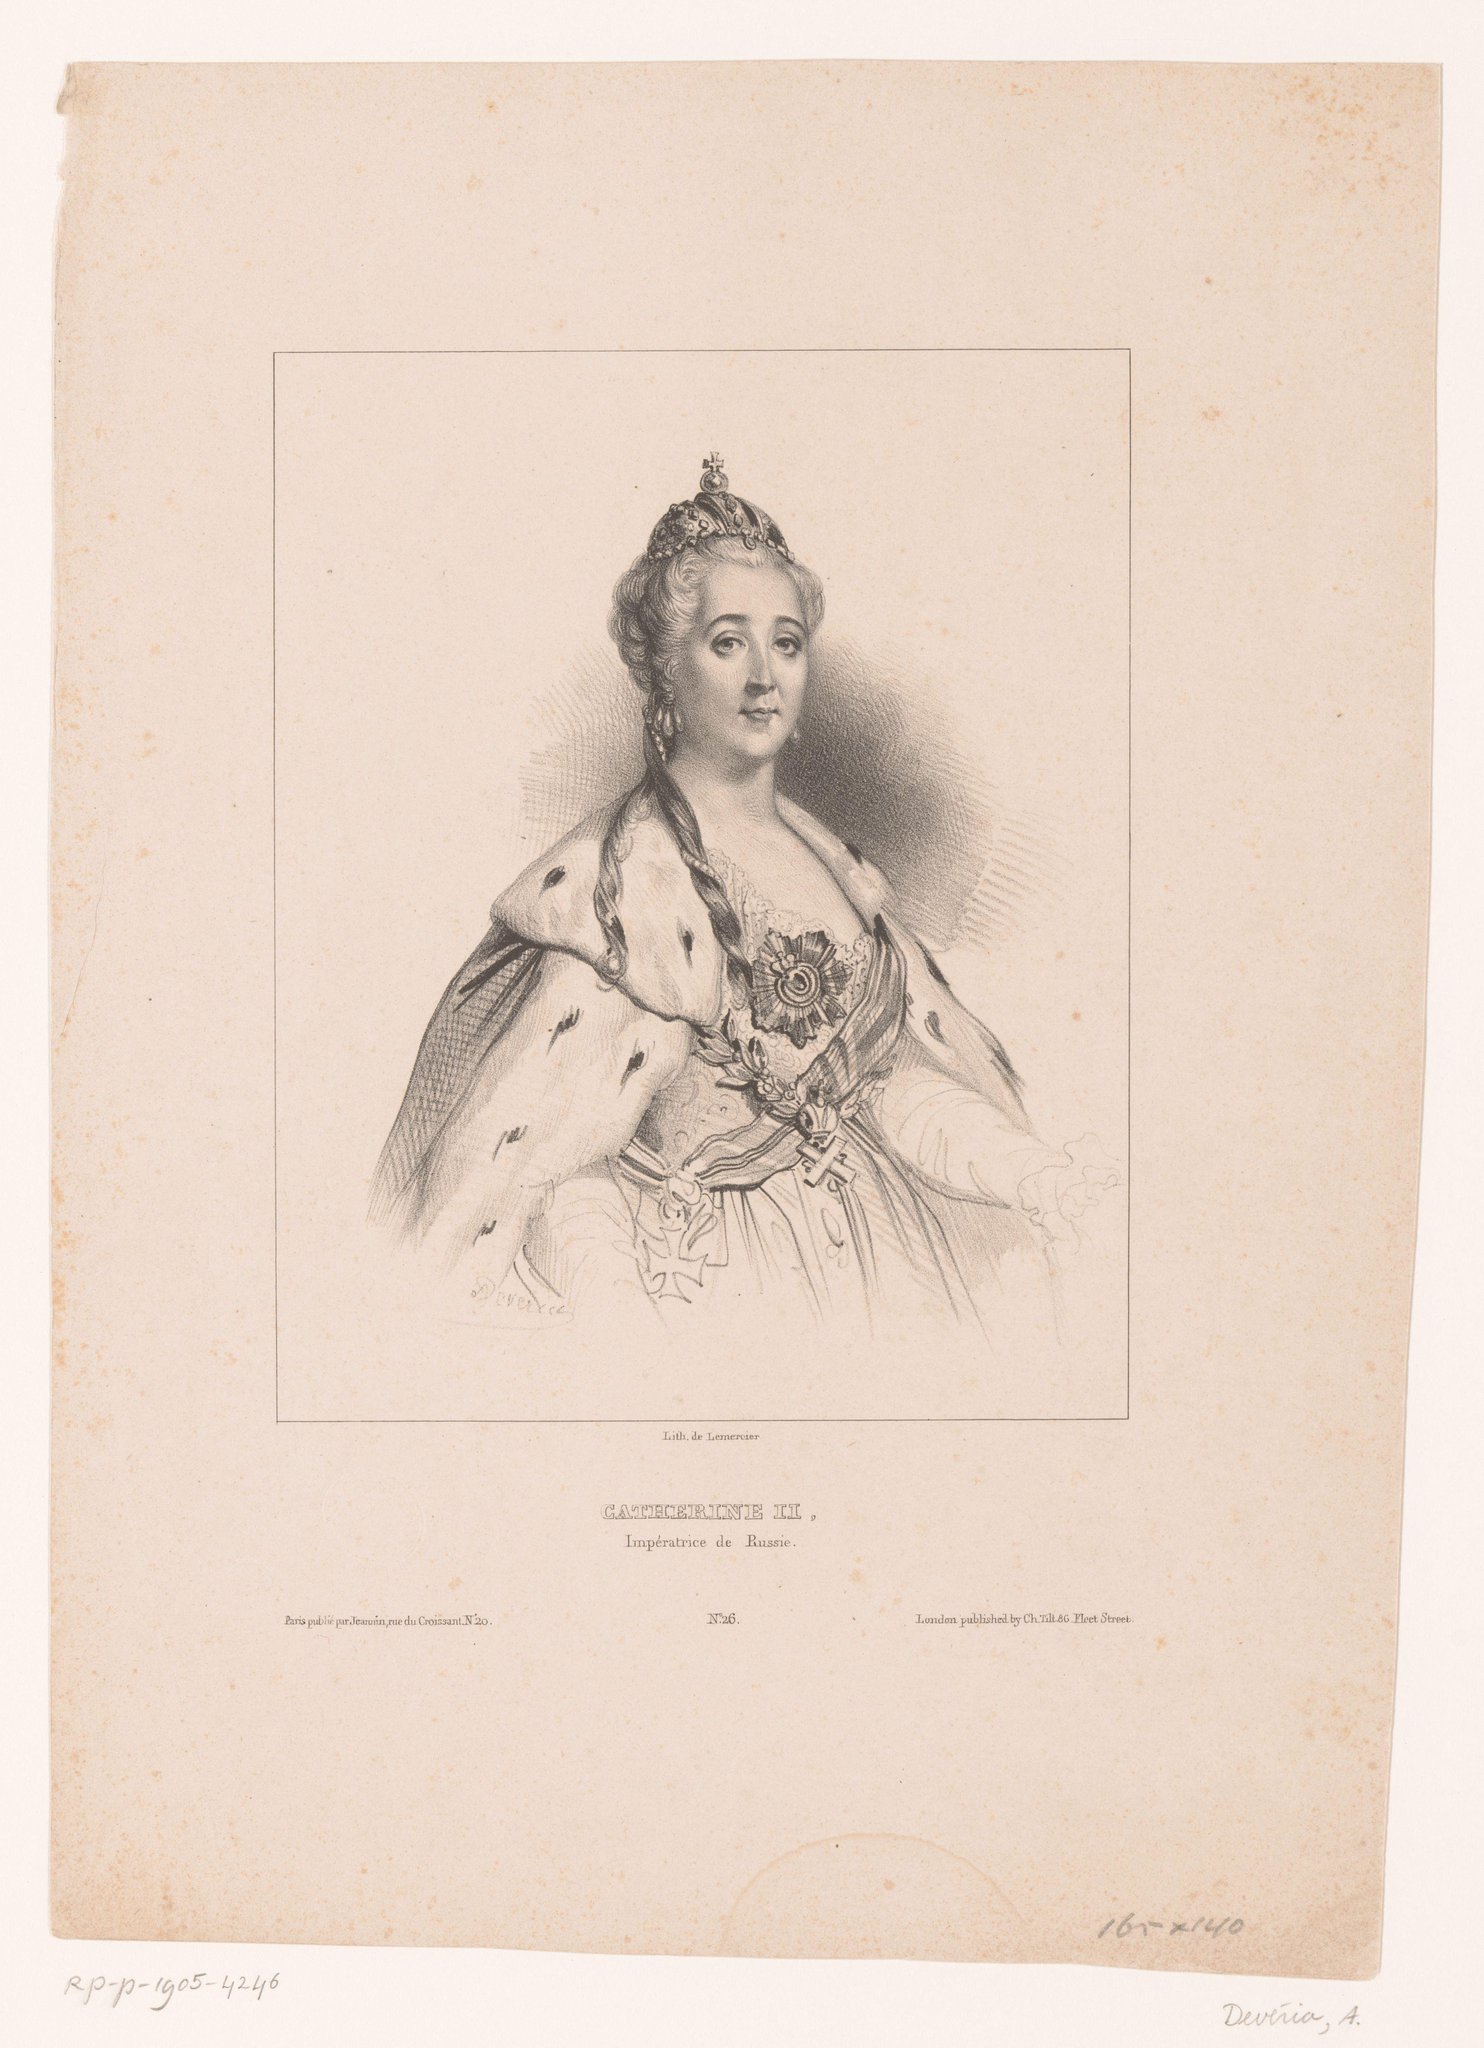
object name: print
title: Beroemde vrouwen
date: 1832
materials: paper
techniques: lithograph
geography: paris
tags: catharina de grote, historical persons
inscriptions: check stamp: Lugt 3987, collector's mark: Lugt 2228a